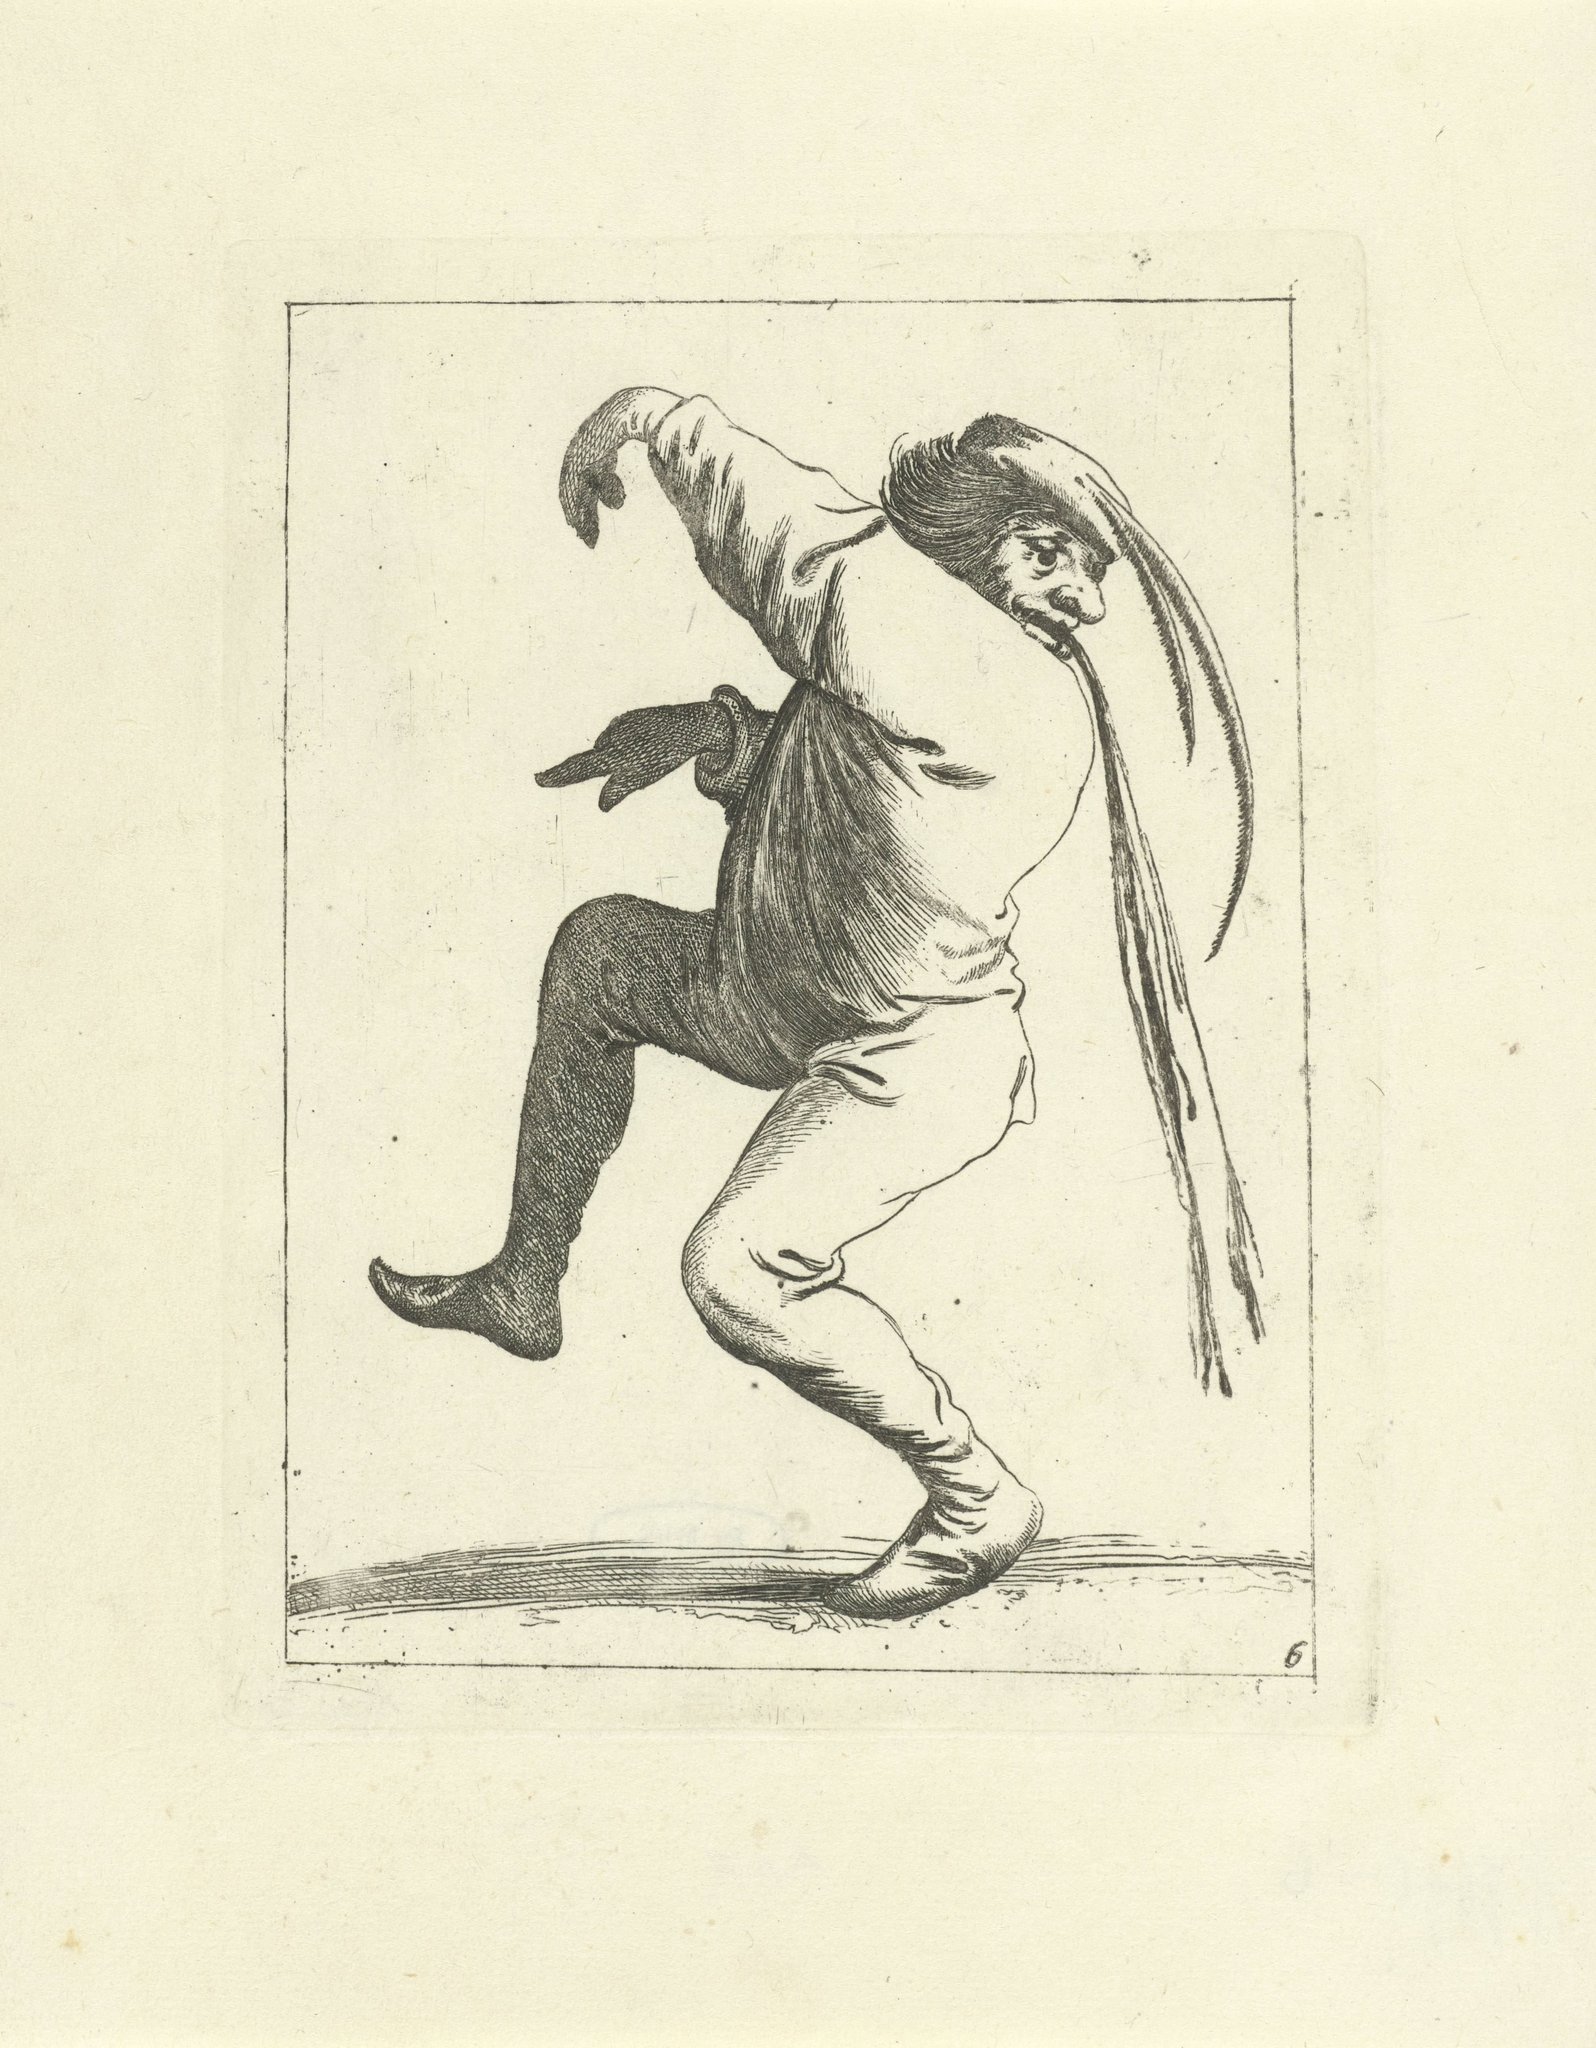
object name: print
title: Twaalf dwazen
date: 1639-1706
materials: paper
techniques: engraving, etching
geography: amsterdam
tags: fool, simpleton, numskull, vomiting, head-gear (+ feathers used for clothes)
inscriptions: collector's mark: Lugt 2228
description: Een dwaas, met een hoed met veren op zijn hoofd, braakt precies over zijn schouder op de grond. De prent maakt deel uit van een serie van twaalf prenten met dwazen.